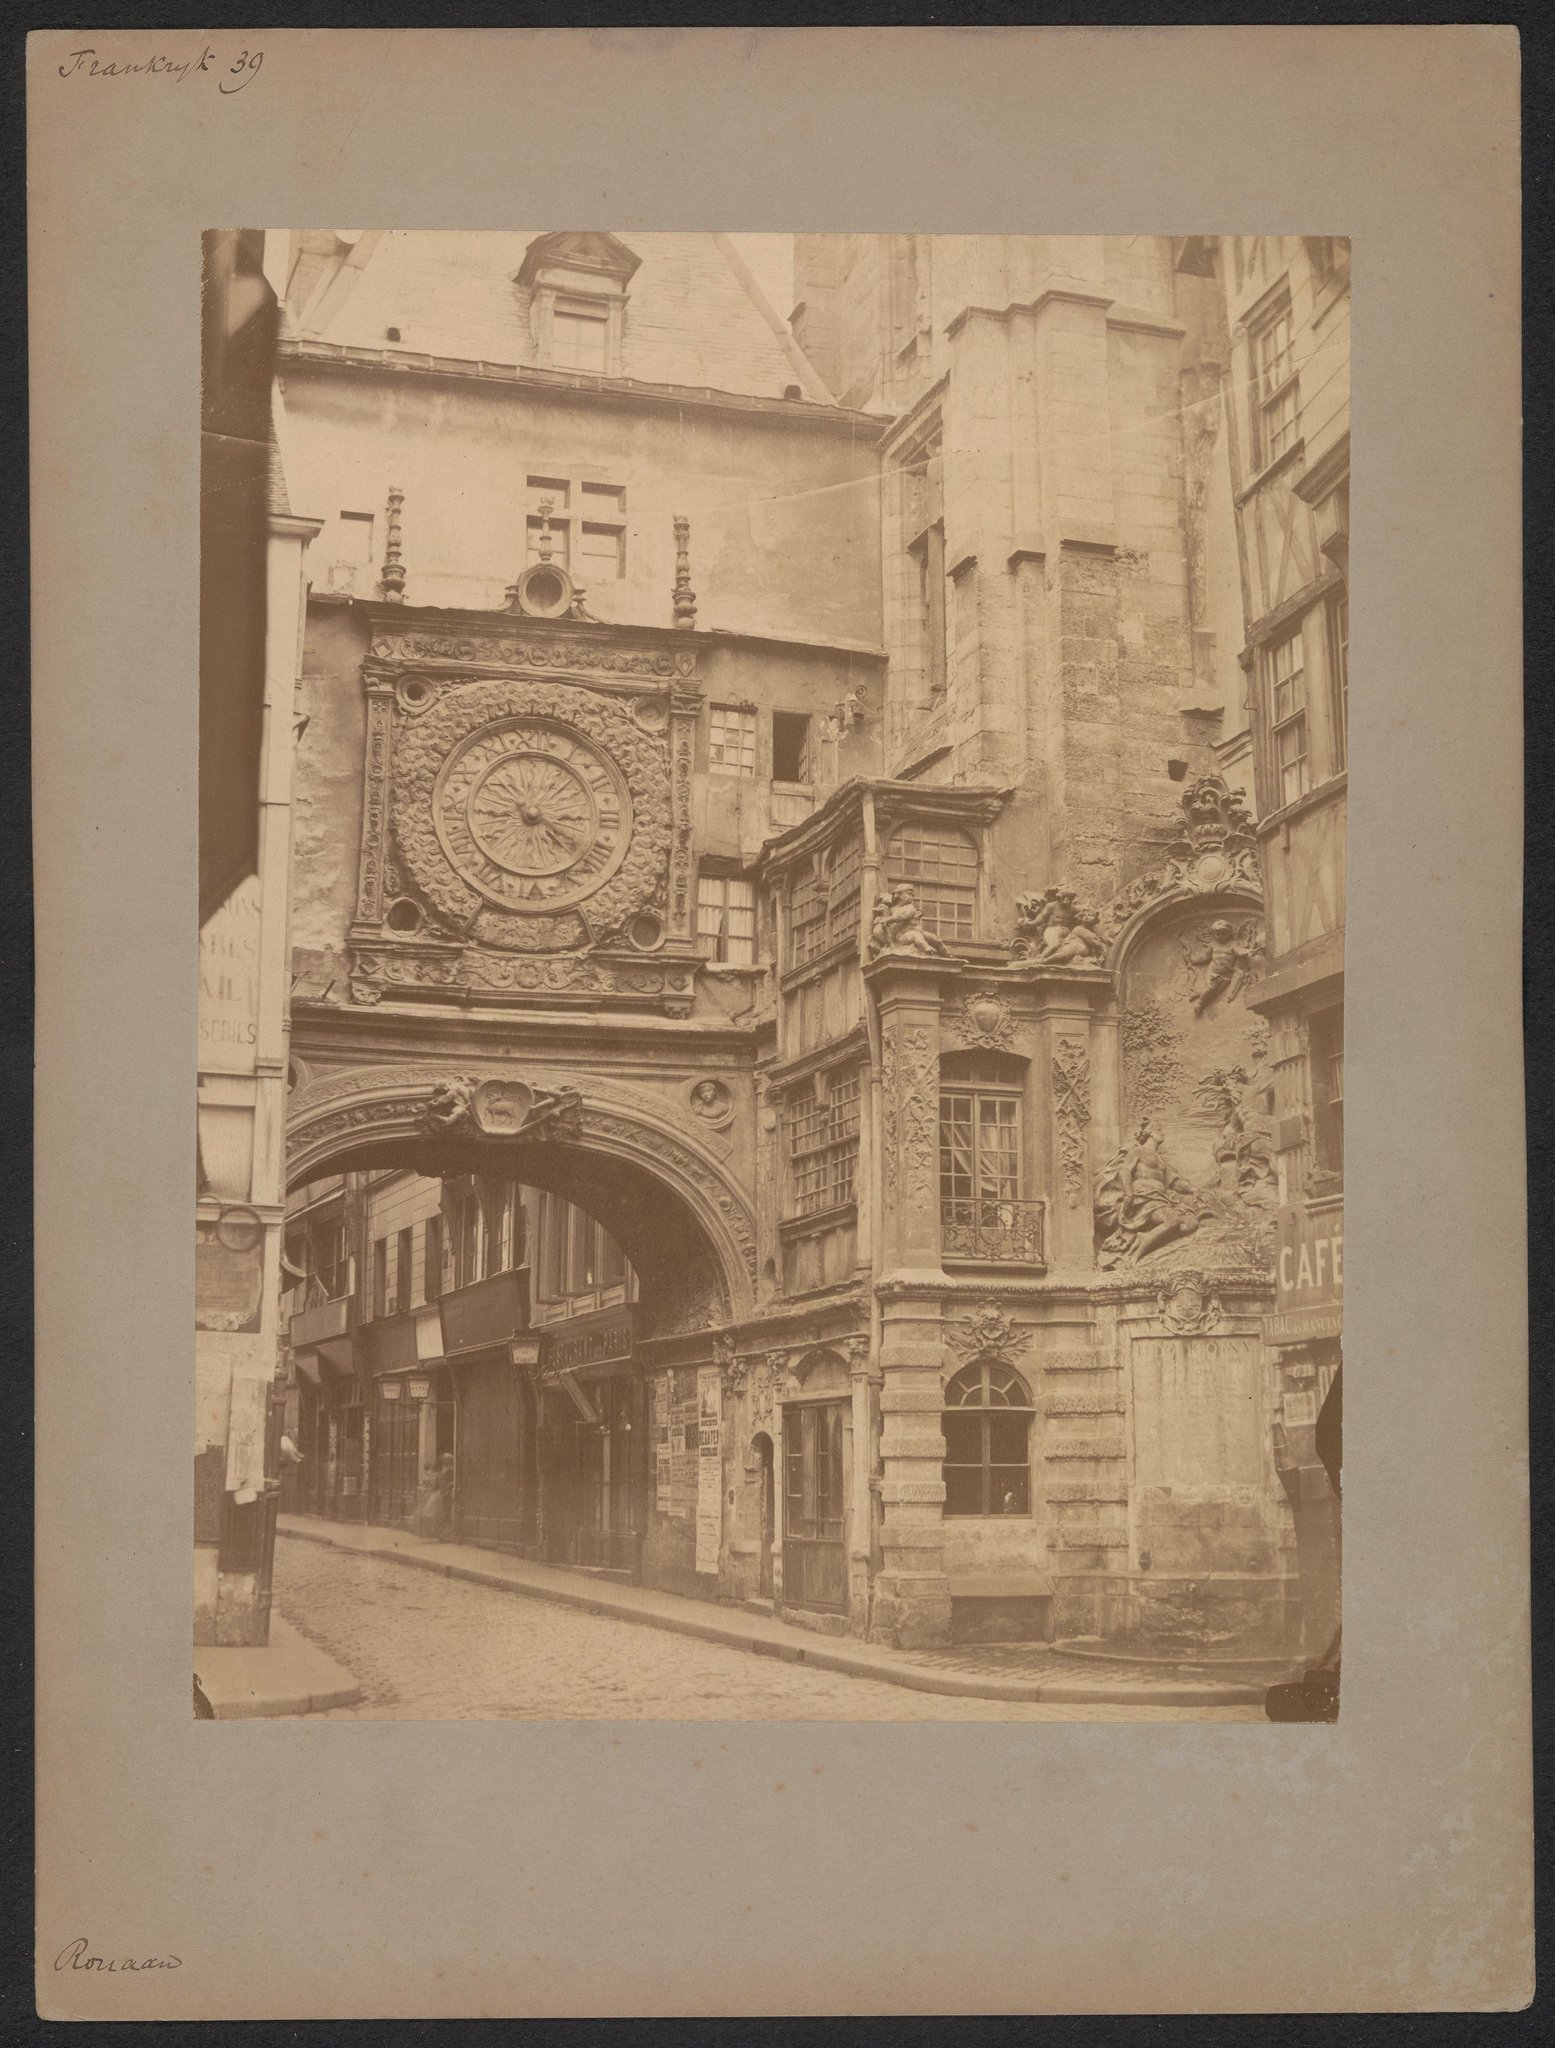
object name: photograph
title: Gezicht op het Gros-Horloge in Rouen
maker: Anonymous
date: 1850-1900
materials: cardboard, photographic support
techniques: albumen print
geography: gros-horloge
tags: arch, archivolt ~ architecture, clock, street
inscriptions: annotation: ‘Frankrijk 39’, annotation: ‘Rouen/ De groote he[...]’, collector's mark: ‘RIJKS [NORMA]ALSCHOOL voor T[EEKENONDERWIJZERS] AMSTERDAM’, annotation: ‘Rouaan’